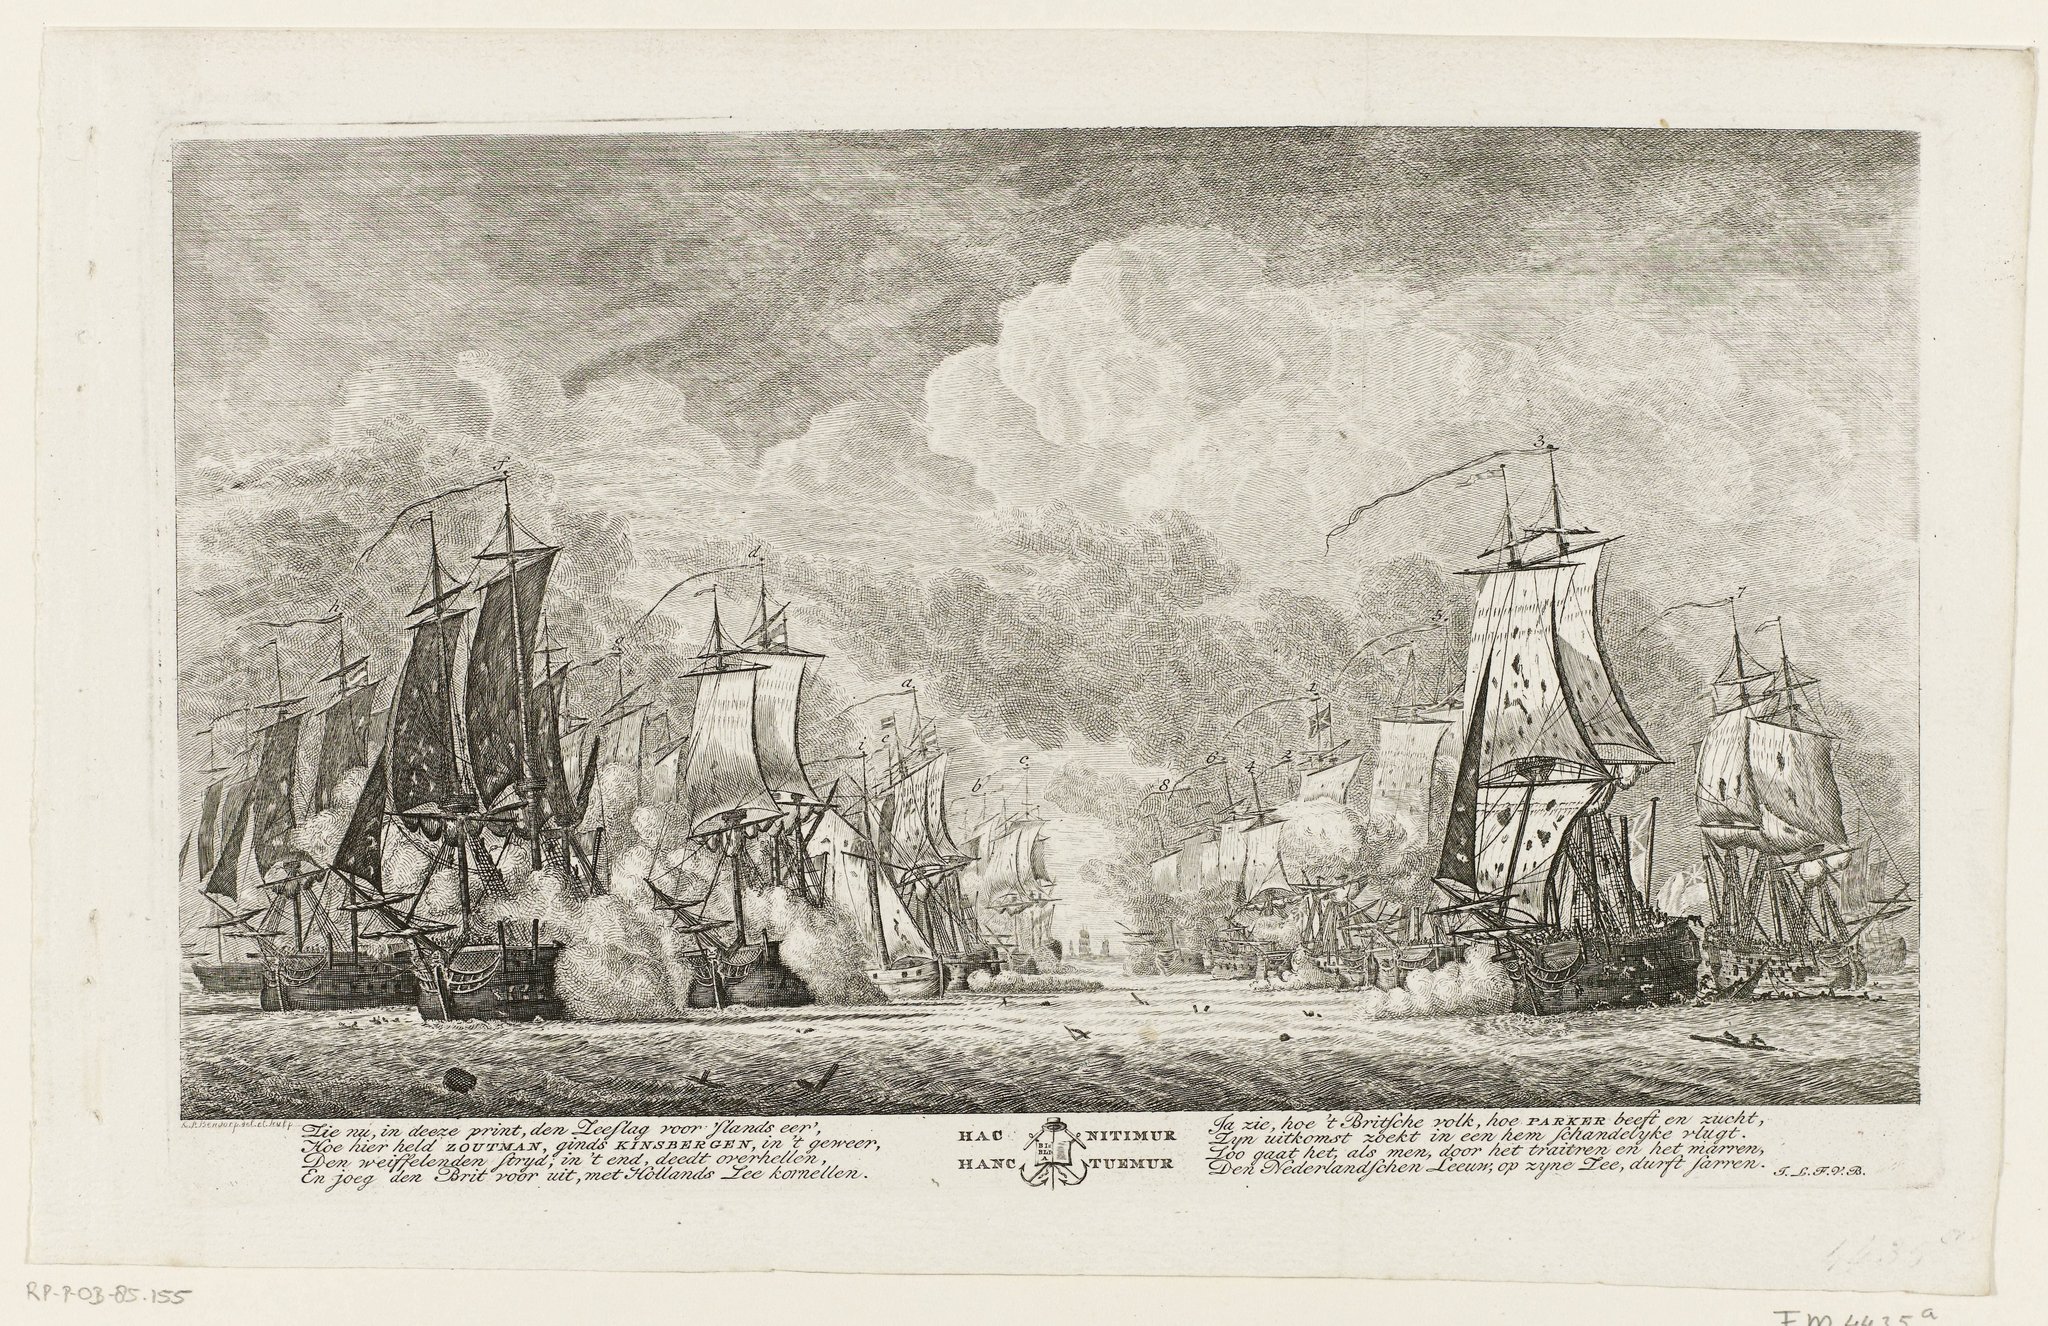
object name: print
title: Zeeslag bij Doggersbank, 1781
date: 1781-1782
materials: paper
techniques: engraving, etching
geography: northern netherlands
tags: johan arnold zoutman, hyde parker, battle (+ naval force)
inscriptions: collector's mark: Lugt 2228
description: De Nederlandse en Engelse schepen tijdens de zeeslag bij Doggersbank op 5 augustus 1781 tussen de Nederlandse vloot onder schout-bij-nacht Johan Zoutman en de Engelse vloot onder vice-admiraal Hyde Parker. In de marge onderaan een achtregelig vers in twee kolommen met in het midden een vignet met twee gekruiste ankers, bijbel en een Latijnse spreuk.